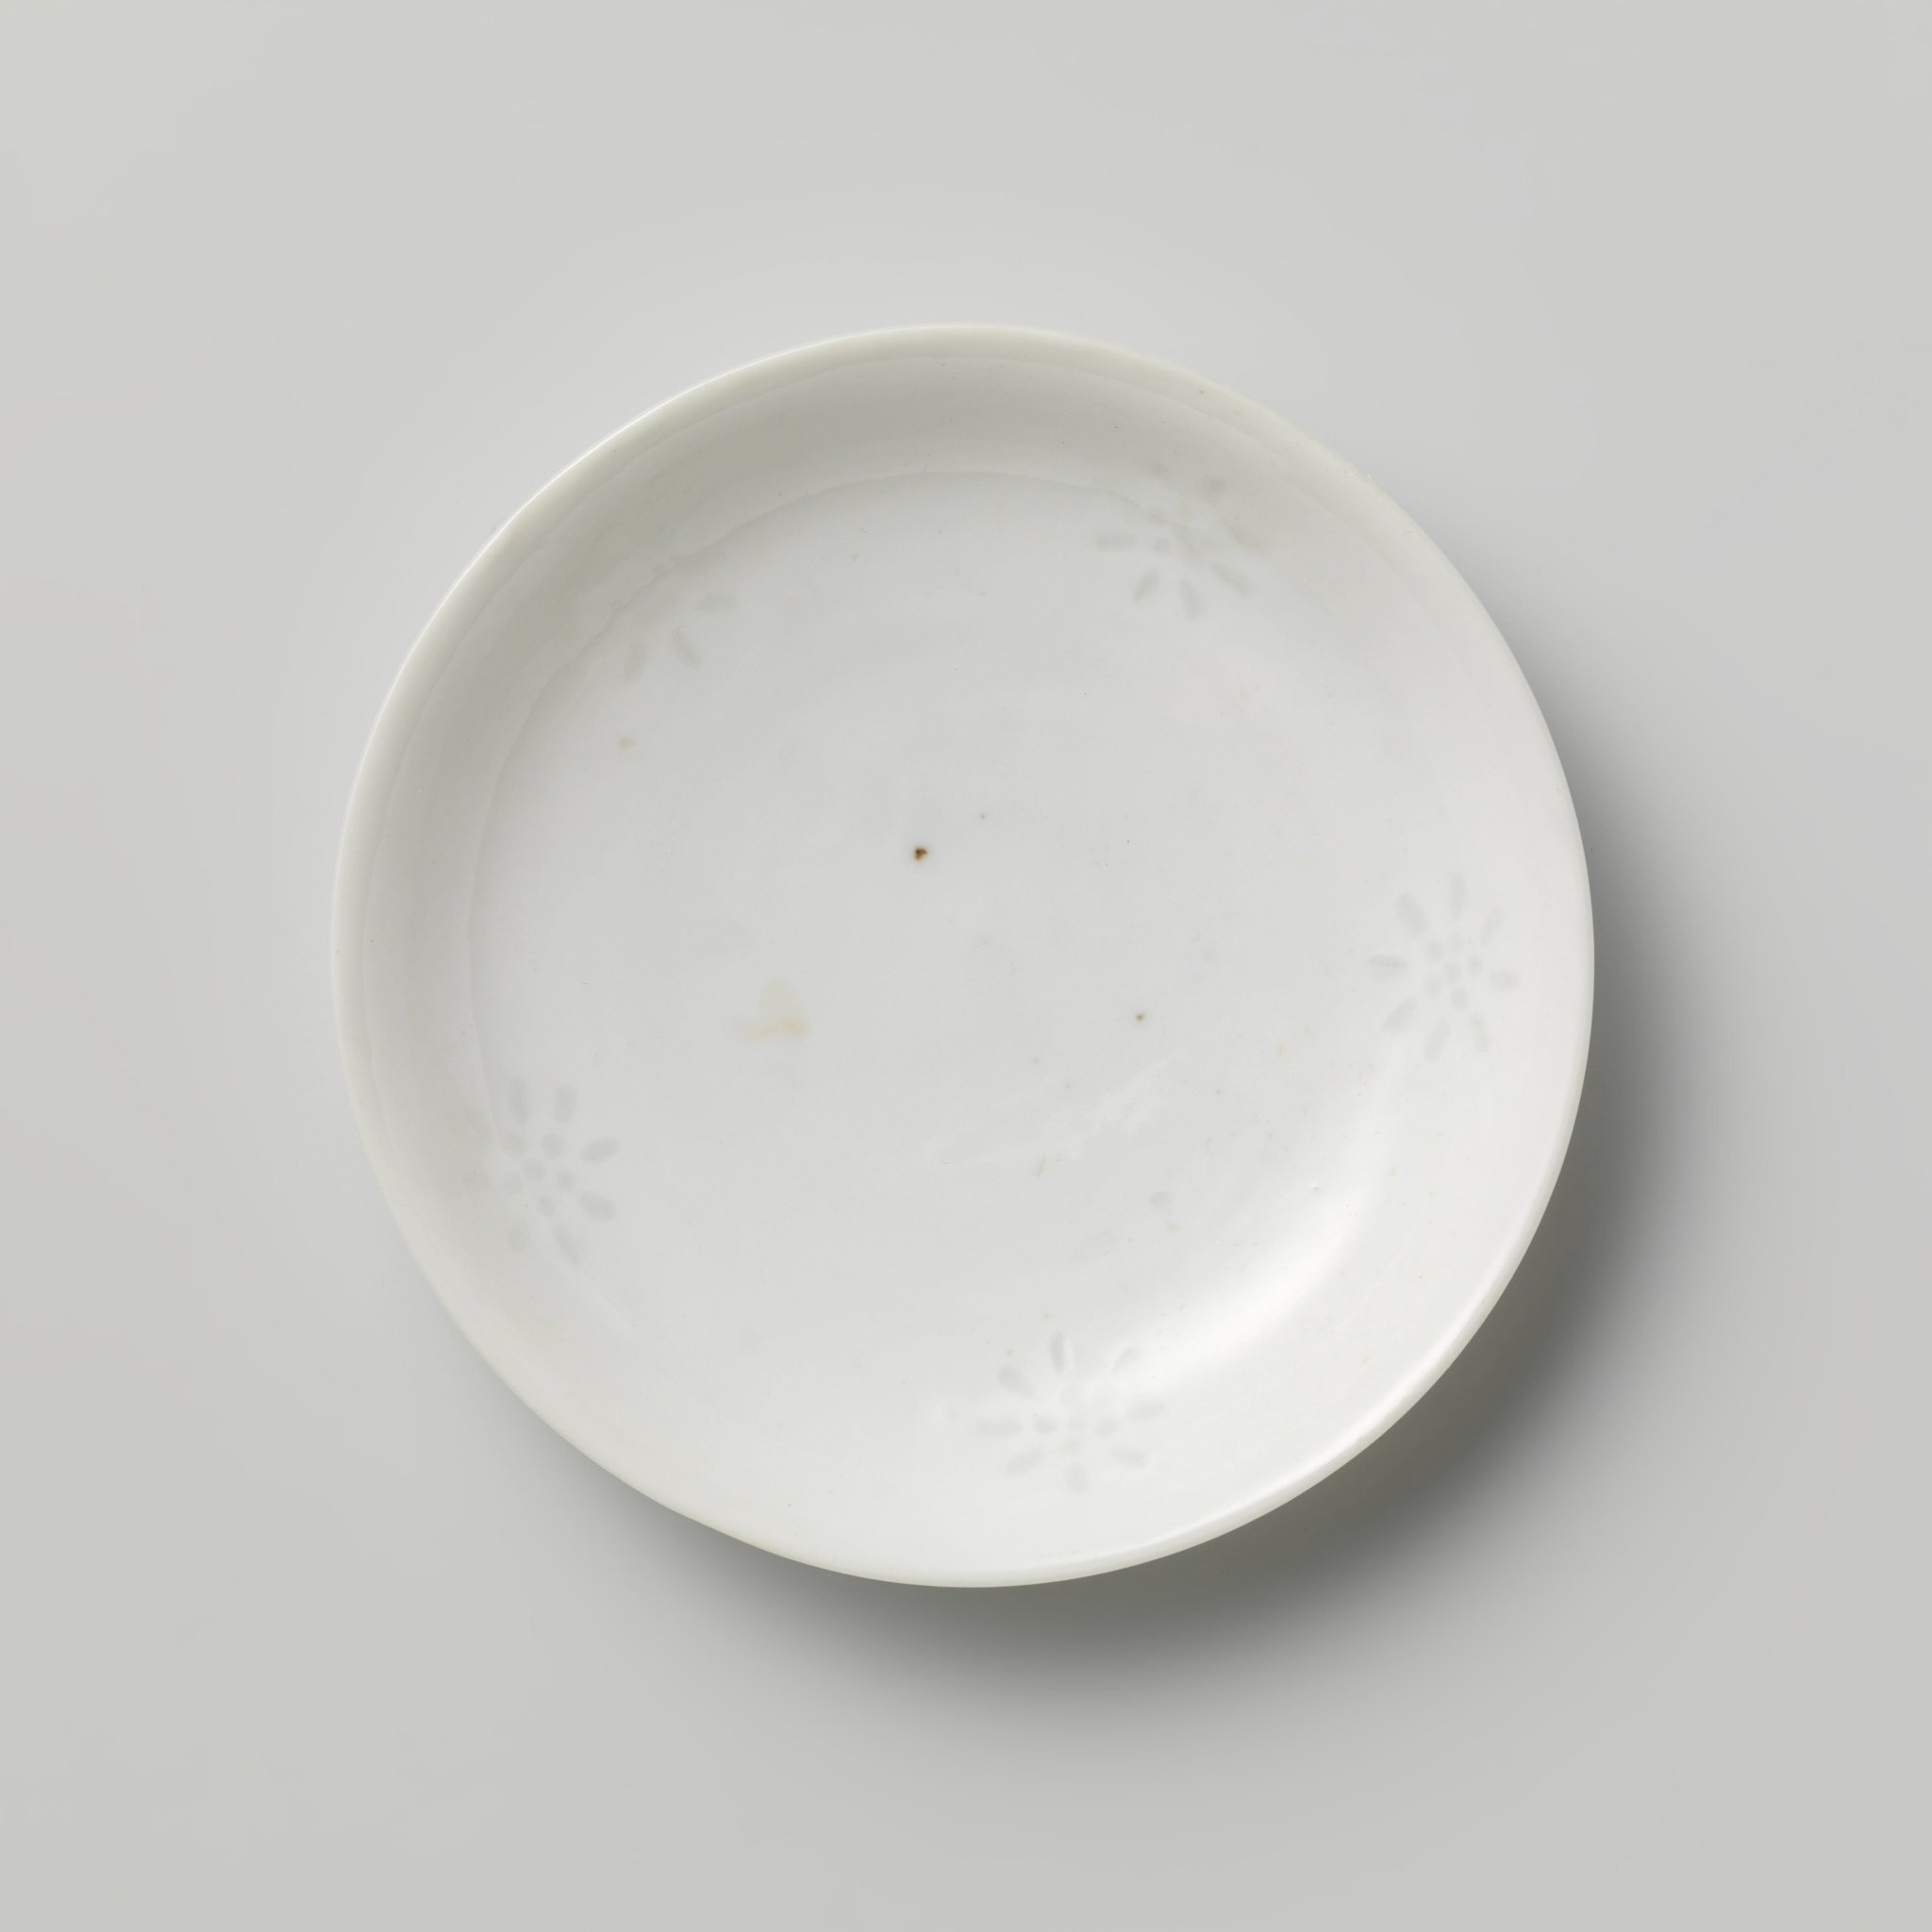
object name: kop en schotel, kop en schotel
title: Saucer with translucents rice-grain roundels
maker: Anonymous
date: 1700-1724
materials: glaze, porcelain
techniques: embroidery, firing, turning, vitrification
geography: jingdezhen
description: Schotel van porselein, bedekt met een doorschijnend wit glazuur. De wanden zijn opengewerkt (ajourwerk) in vijf rozetten van rijstwerk. Wit porselein, monochromen.